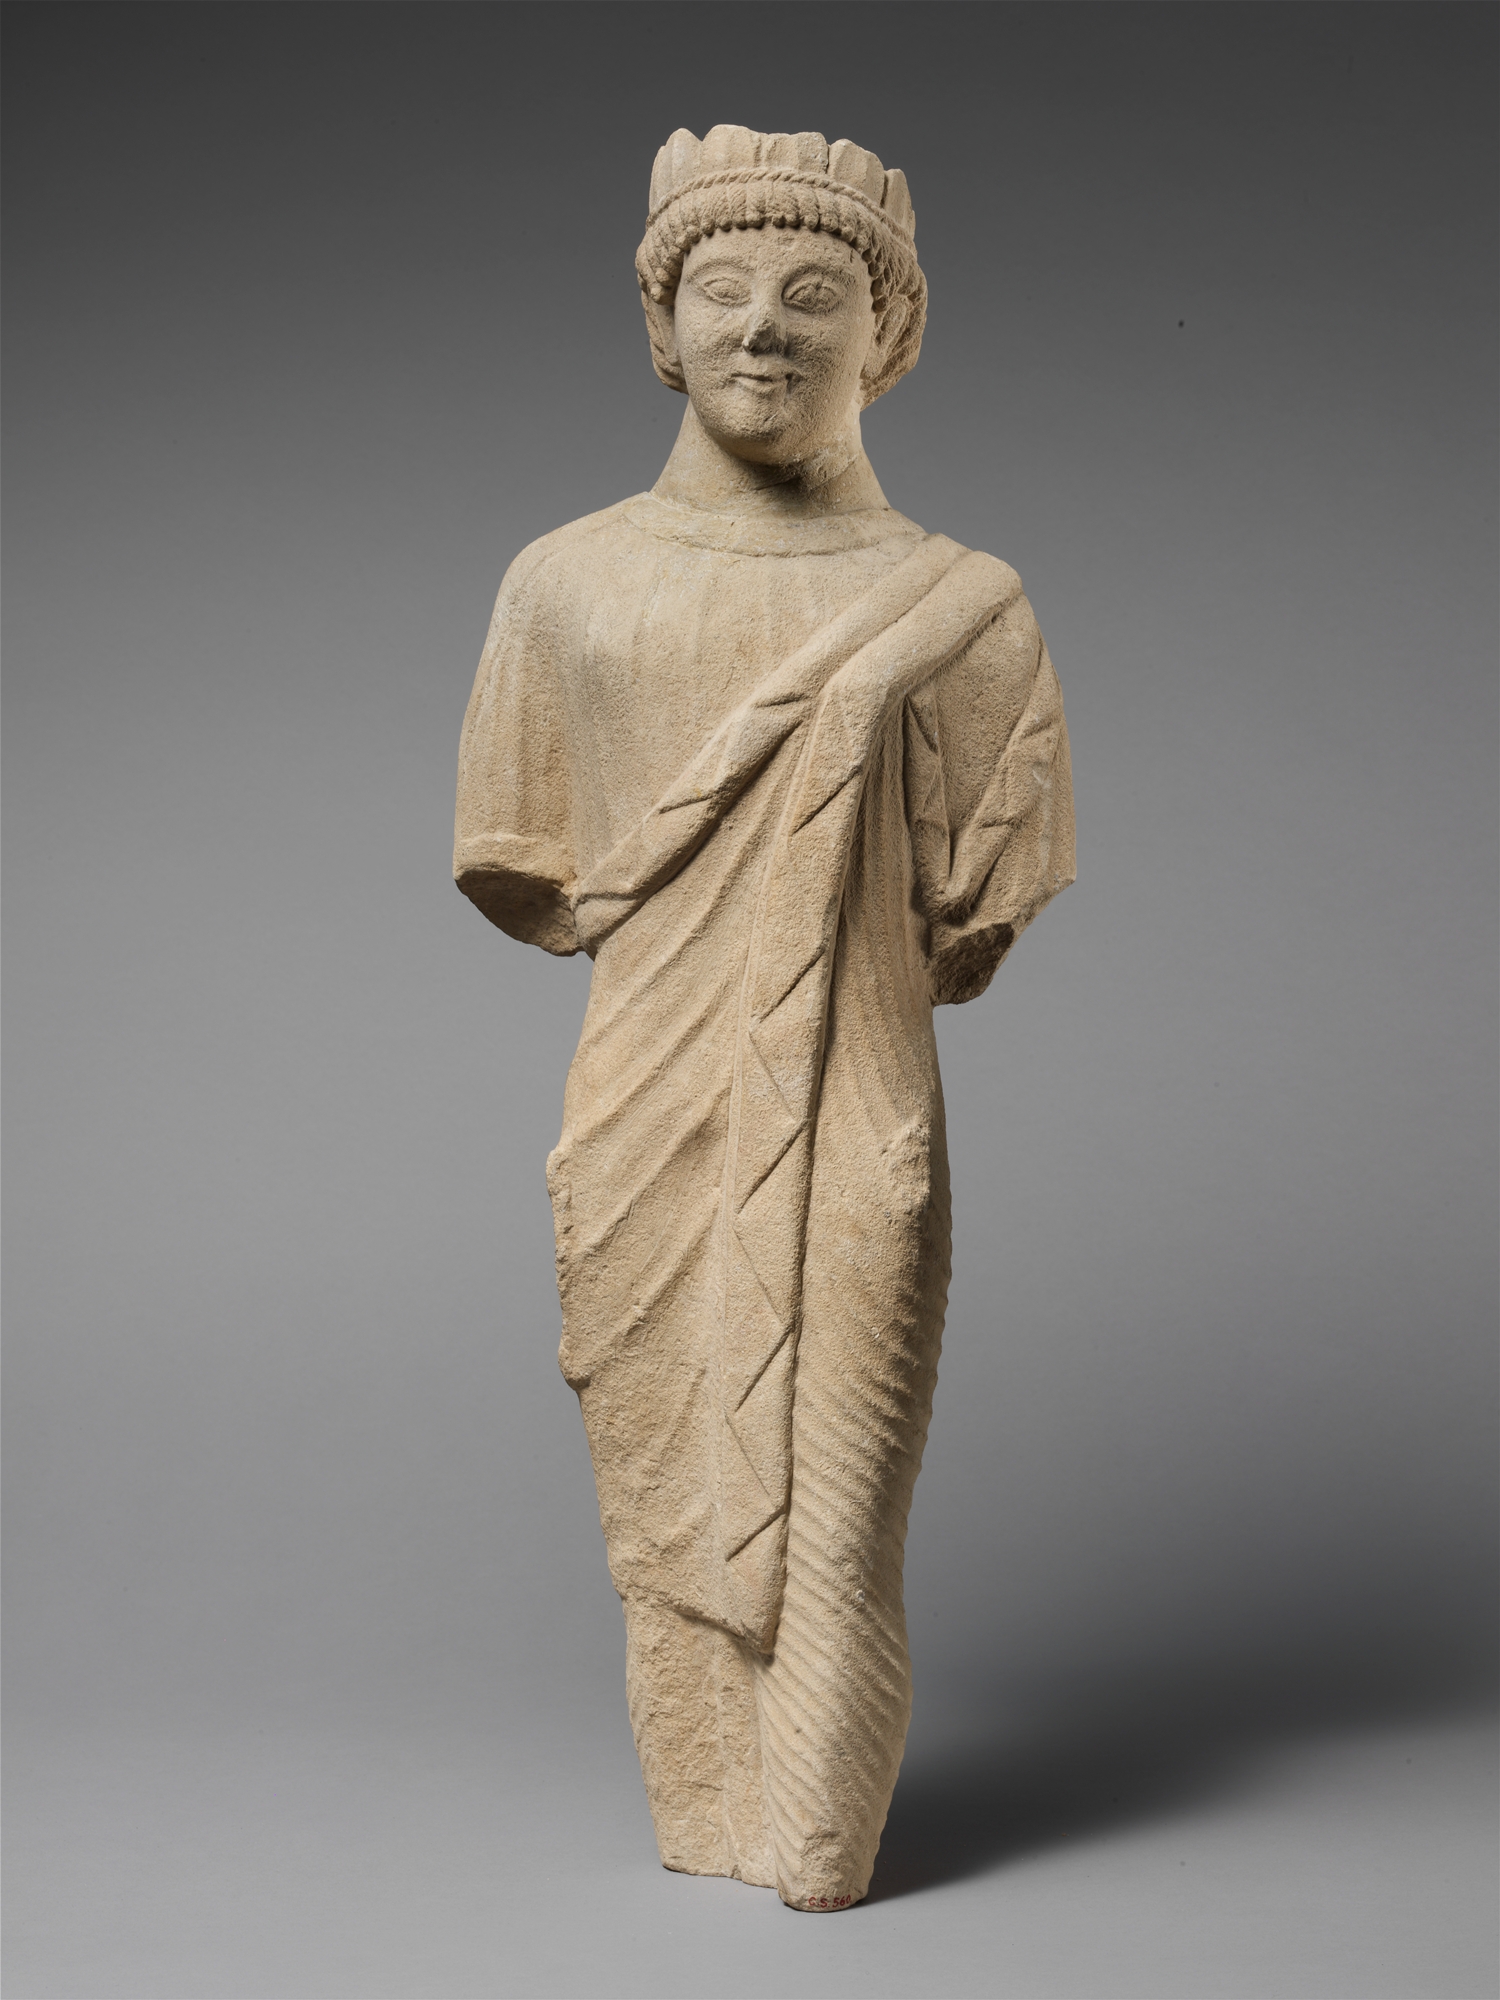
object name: statue of a votary, male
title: Limestone statuette of a beardless male votary in Greek dress with a wreath of leaves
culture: cypriot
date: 500-468 BCE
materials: limestone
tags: men